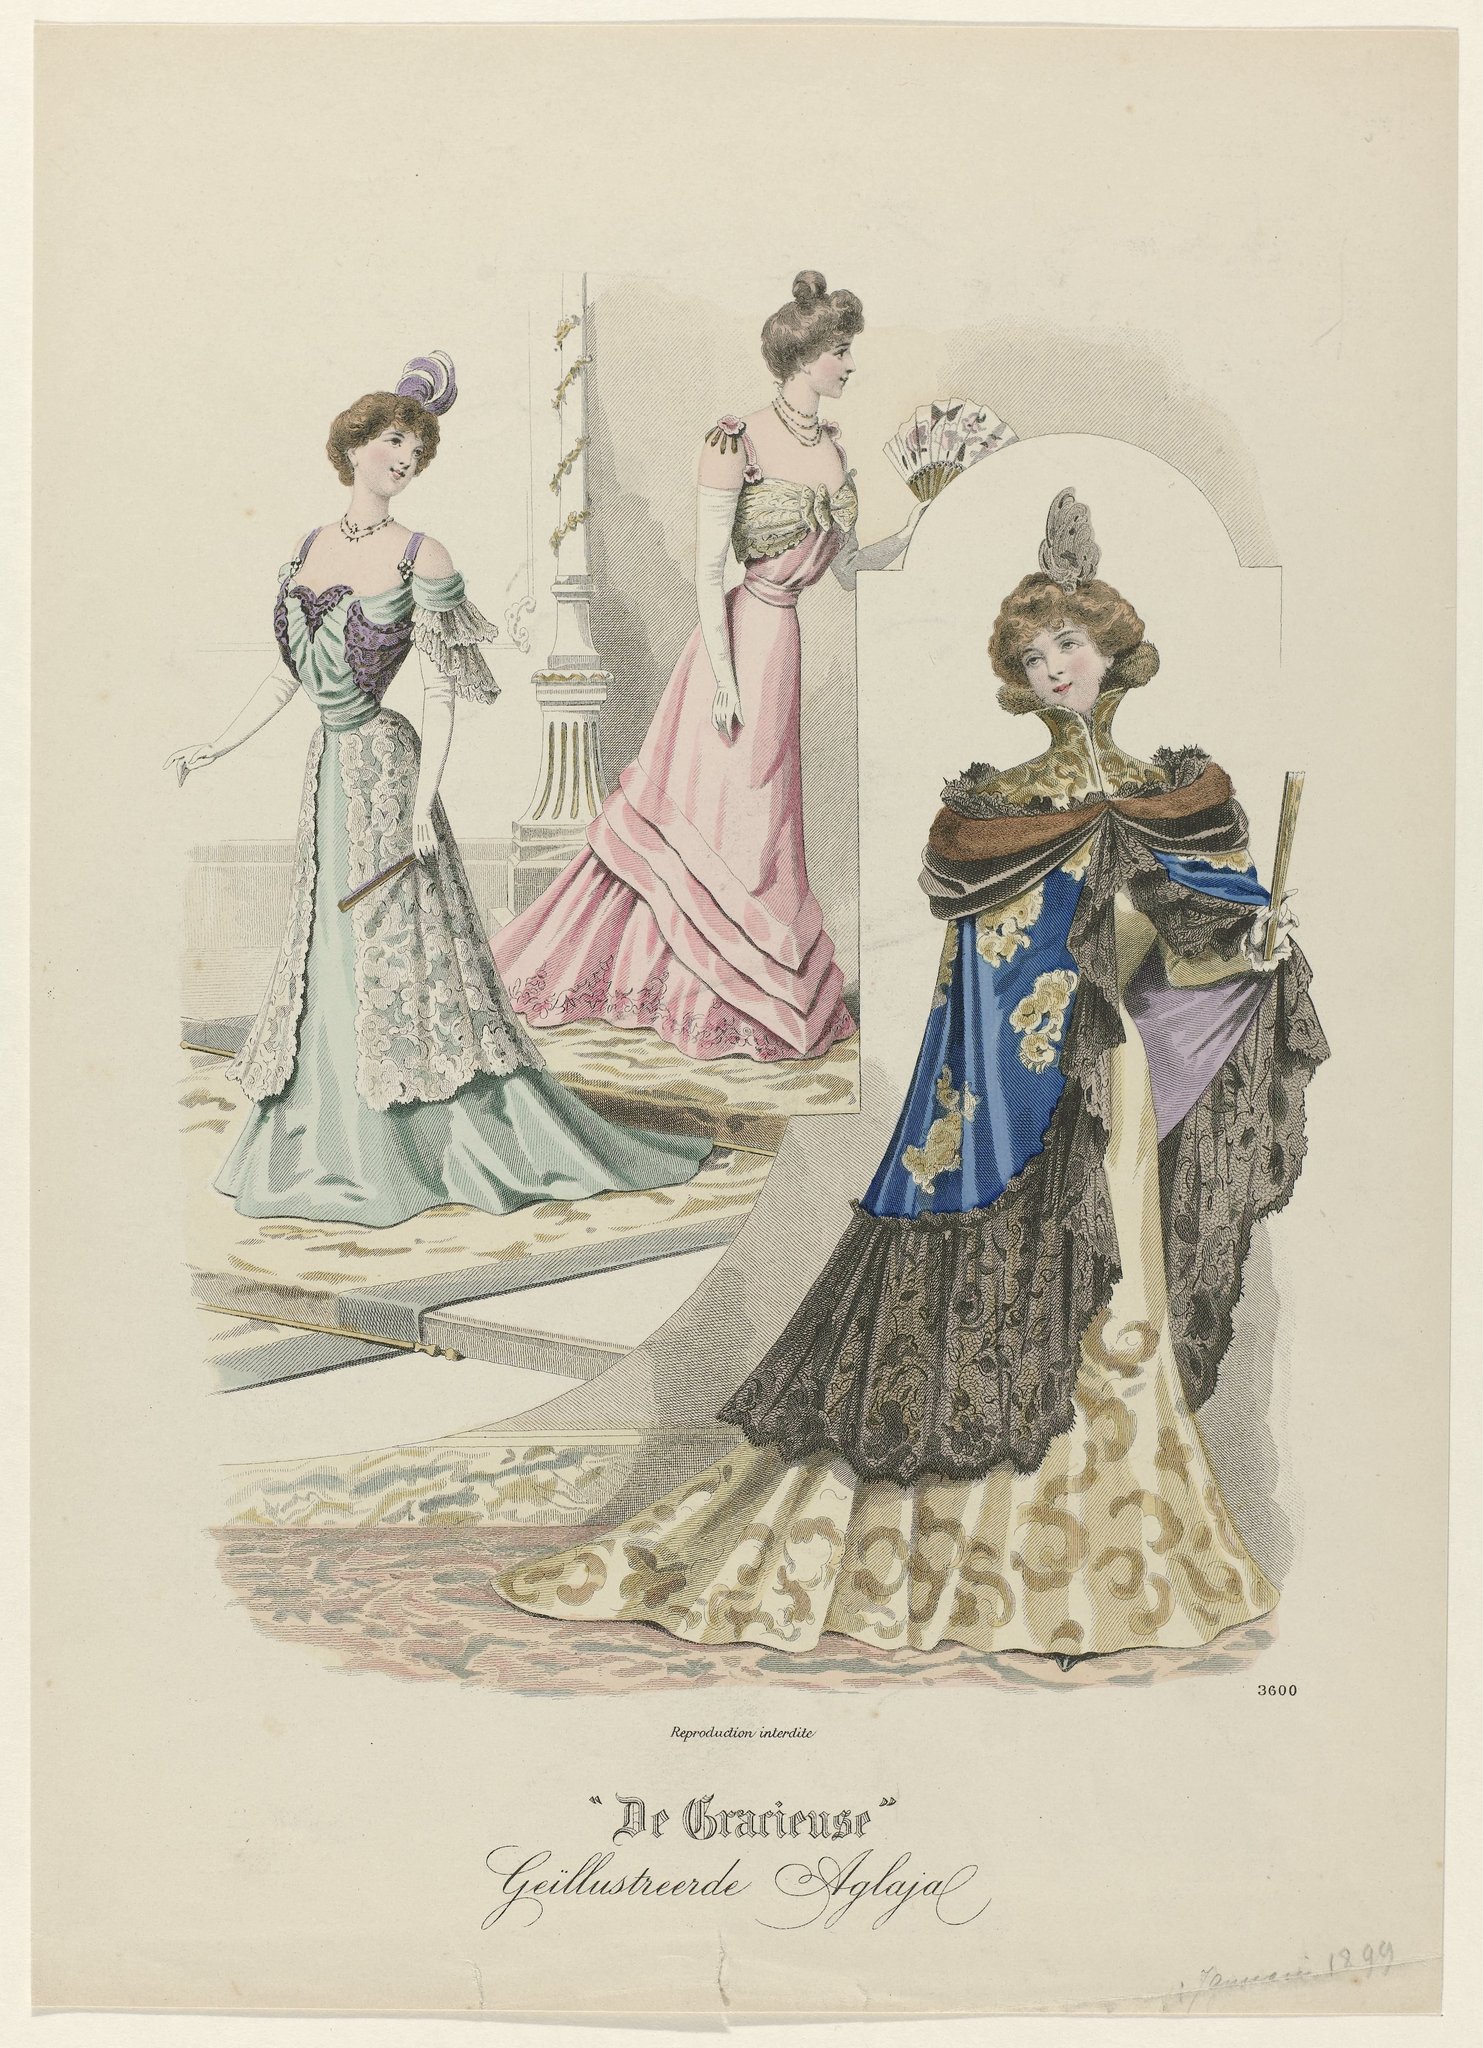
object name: fashion print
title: De Gracieuse, Geïllustreerde Aglaja, januari 1899, No. 3600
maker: Anonymous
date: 1899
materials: paper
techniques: engraving, hand coloring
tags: dress, gown: evening dress (+ women's clothes), gloves, mittens (long gloves) (+ women's clothes), cape (+ women's clothes), fashion plates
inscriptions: title: ‘"De Gracieuse" / Geïllustreerde Aglaja.’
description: Prent uit het modetijdschrift De Gracieuse (1865-1936).